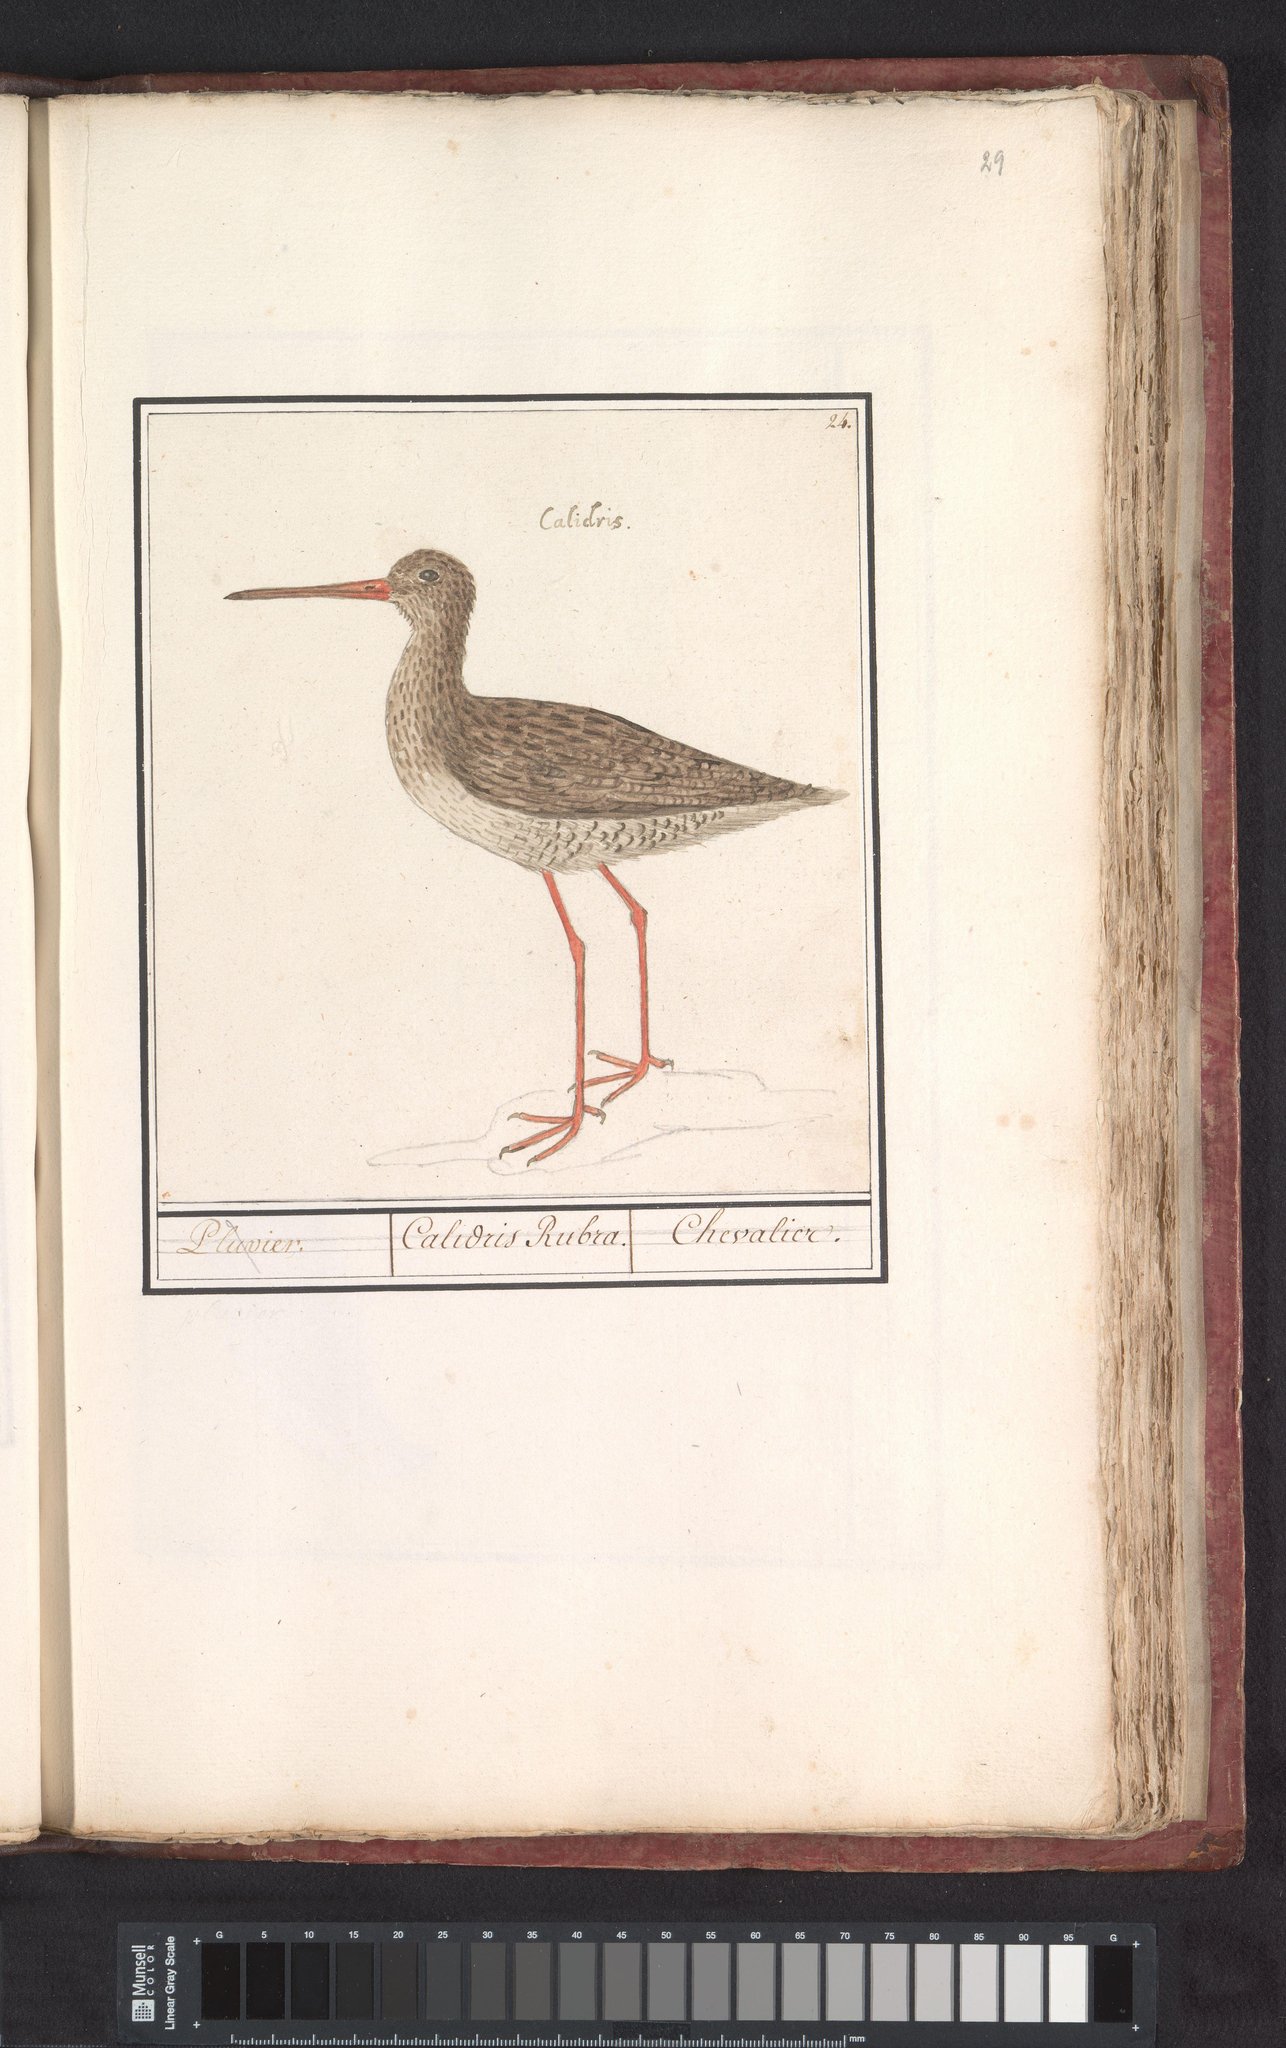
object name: drawing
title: Tureluur (Tringa totanus)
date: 1596-1610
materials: chalk, paint, ink, paper, pencil, watercolor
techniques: brush, pen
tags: shore-birds and wading-birds: redshank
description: Tureluur. Genummerd rechtsboven: 24. Met de Latijnse naam. Onderdeel van het derde album met tekeningen van vogels. Vijfde van twaalf albums met tekeningen van dieren, vogels en planten bekend rond 1600, gemaakt in opdracht van keizer Rudolf II. Met toelichting in Nederlands, Latijn en Frans.